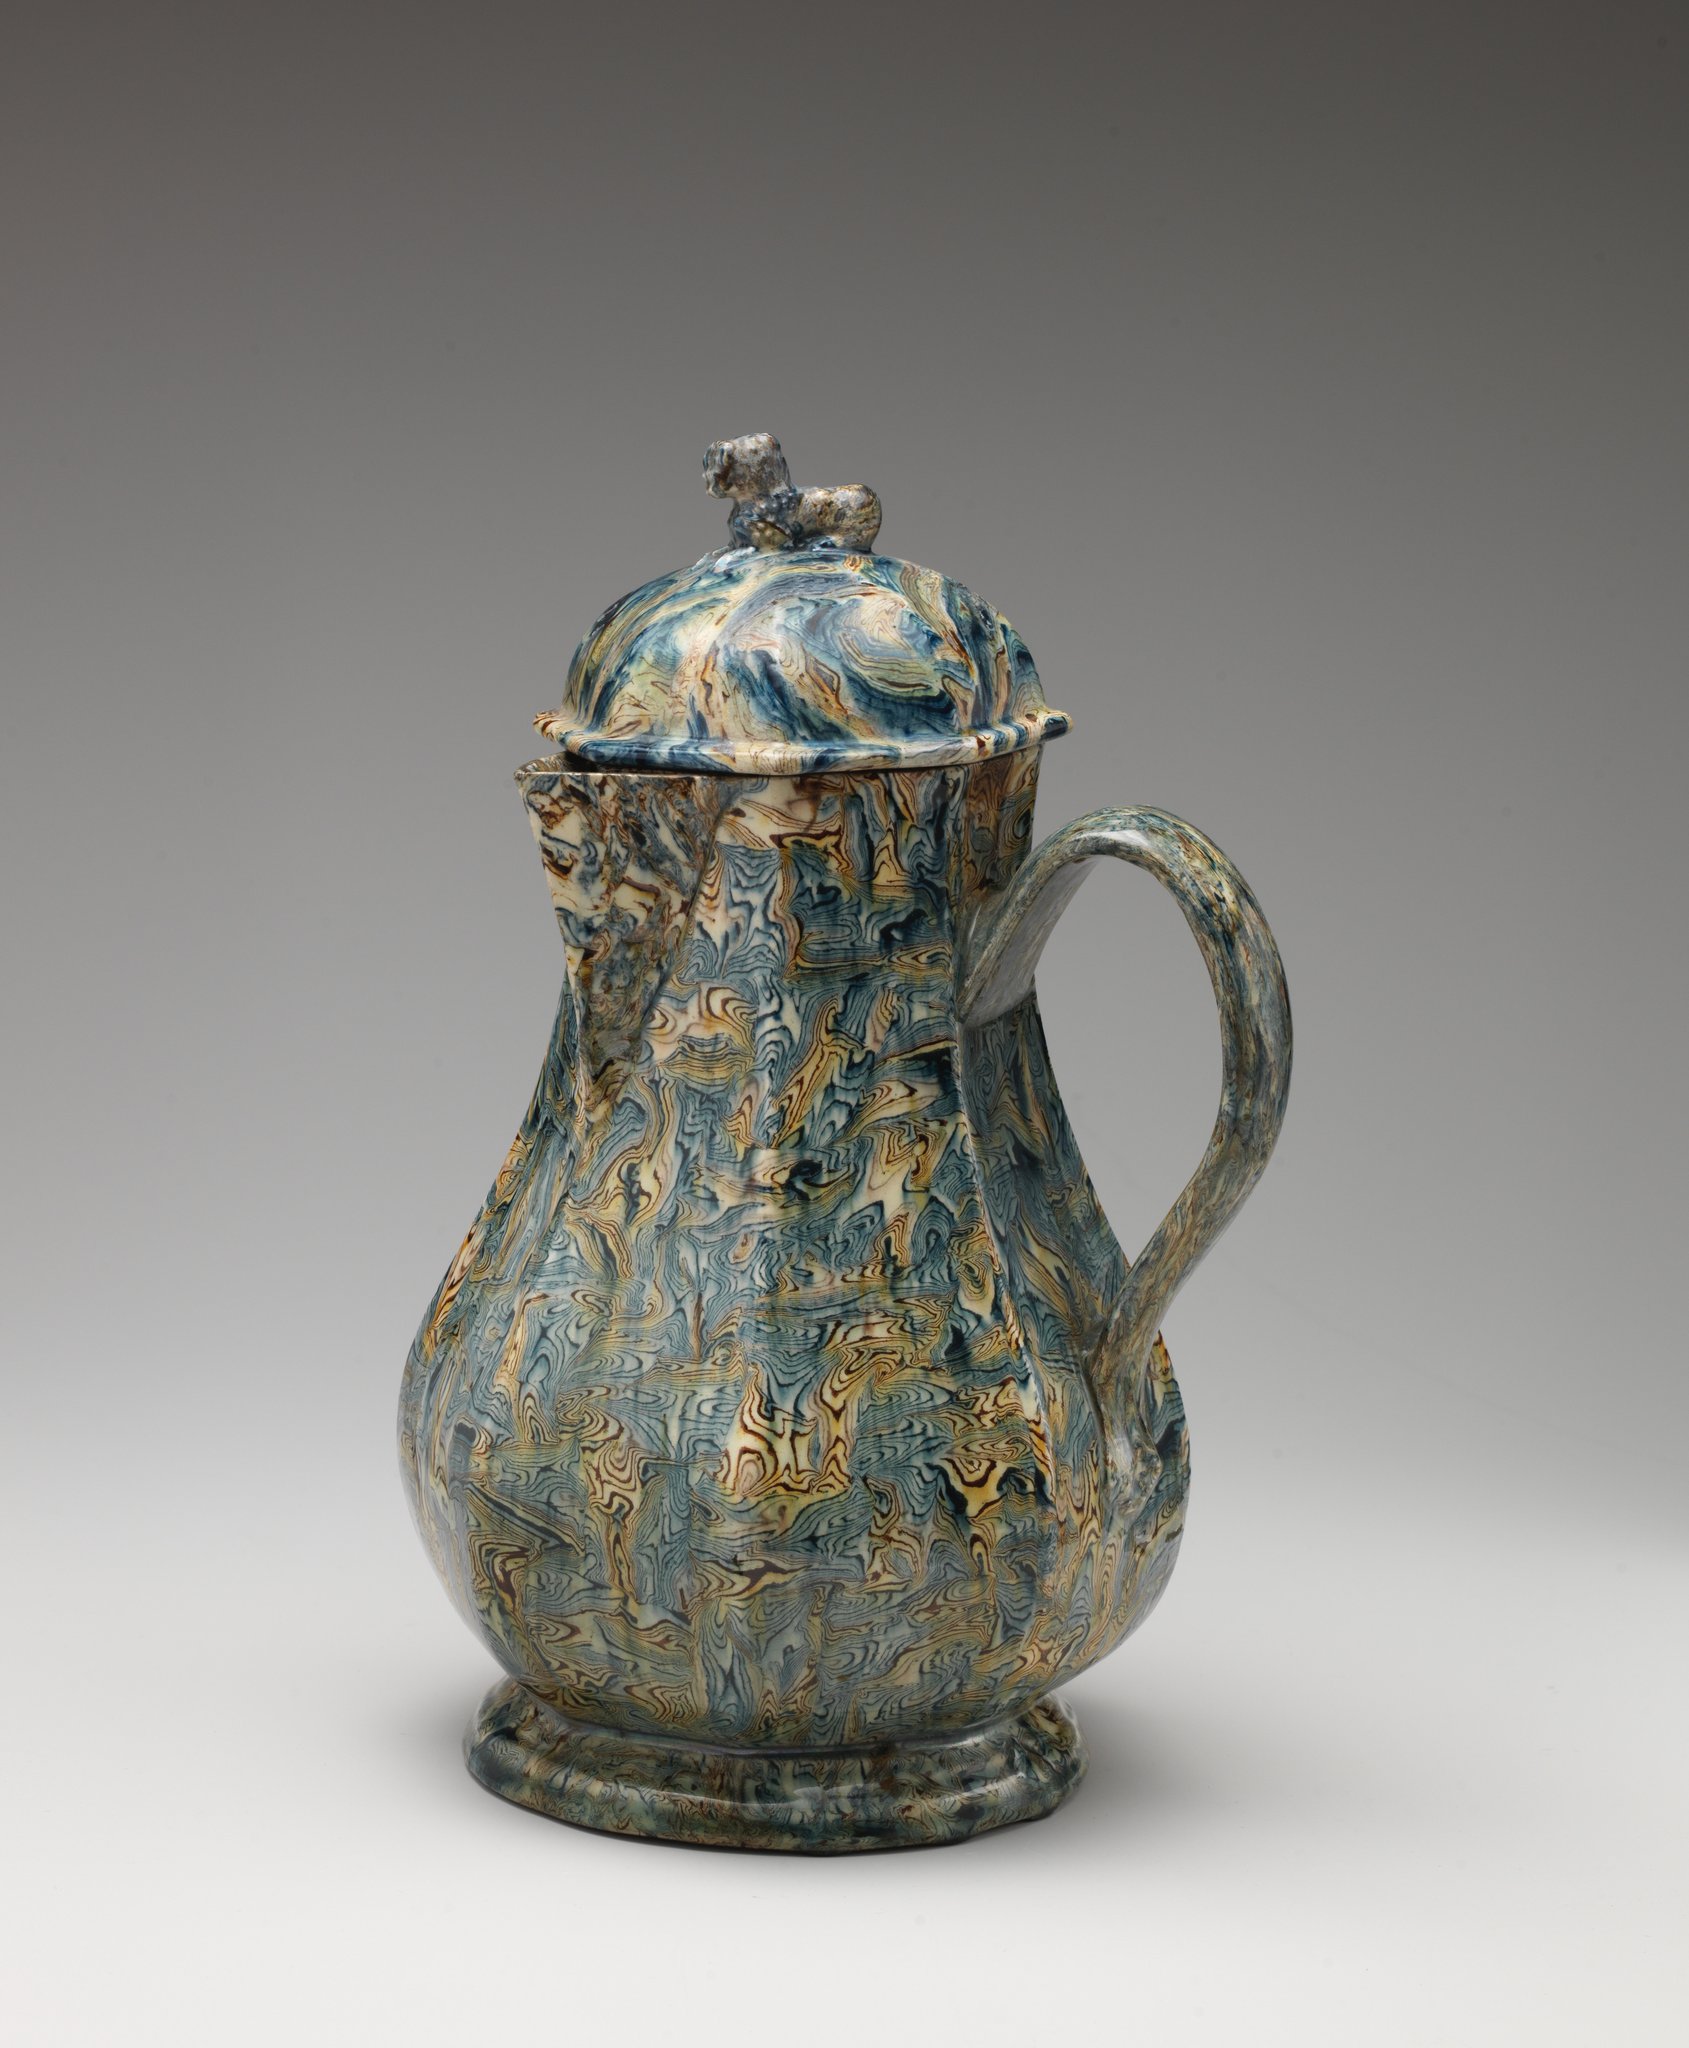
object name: coffeepot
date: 1760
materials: earthenware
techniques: glazing